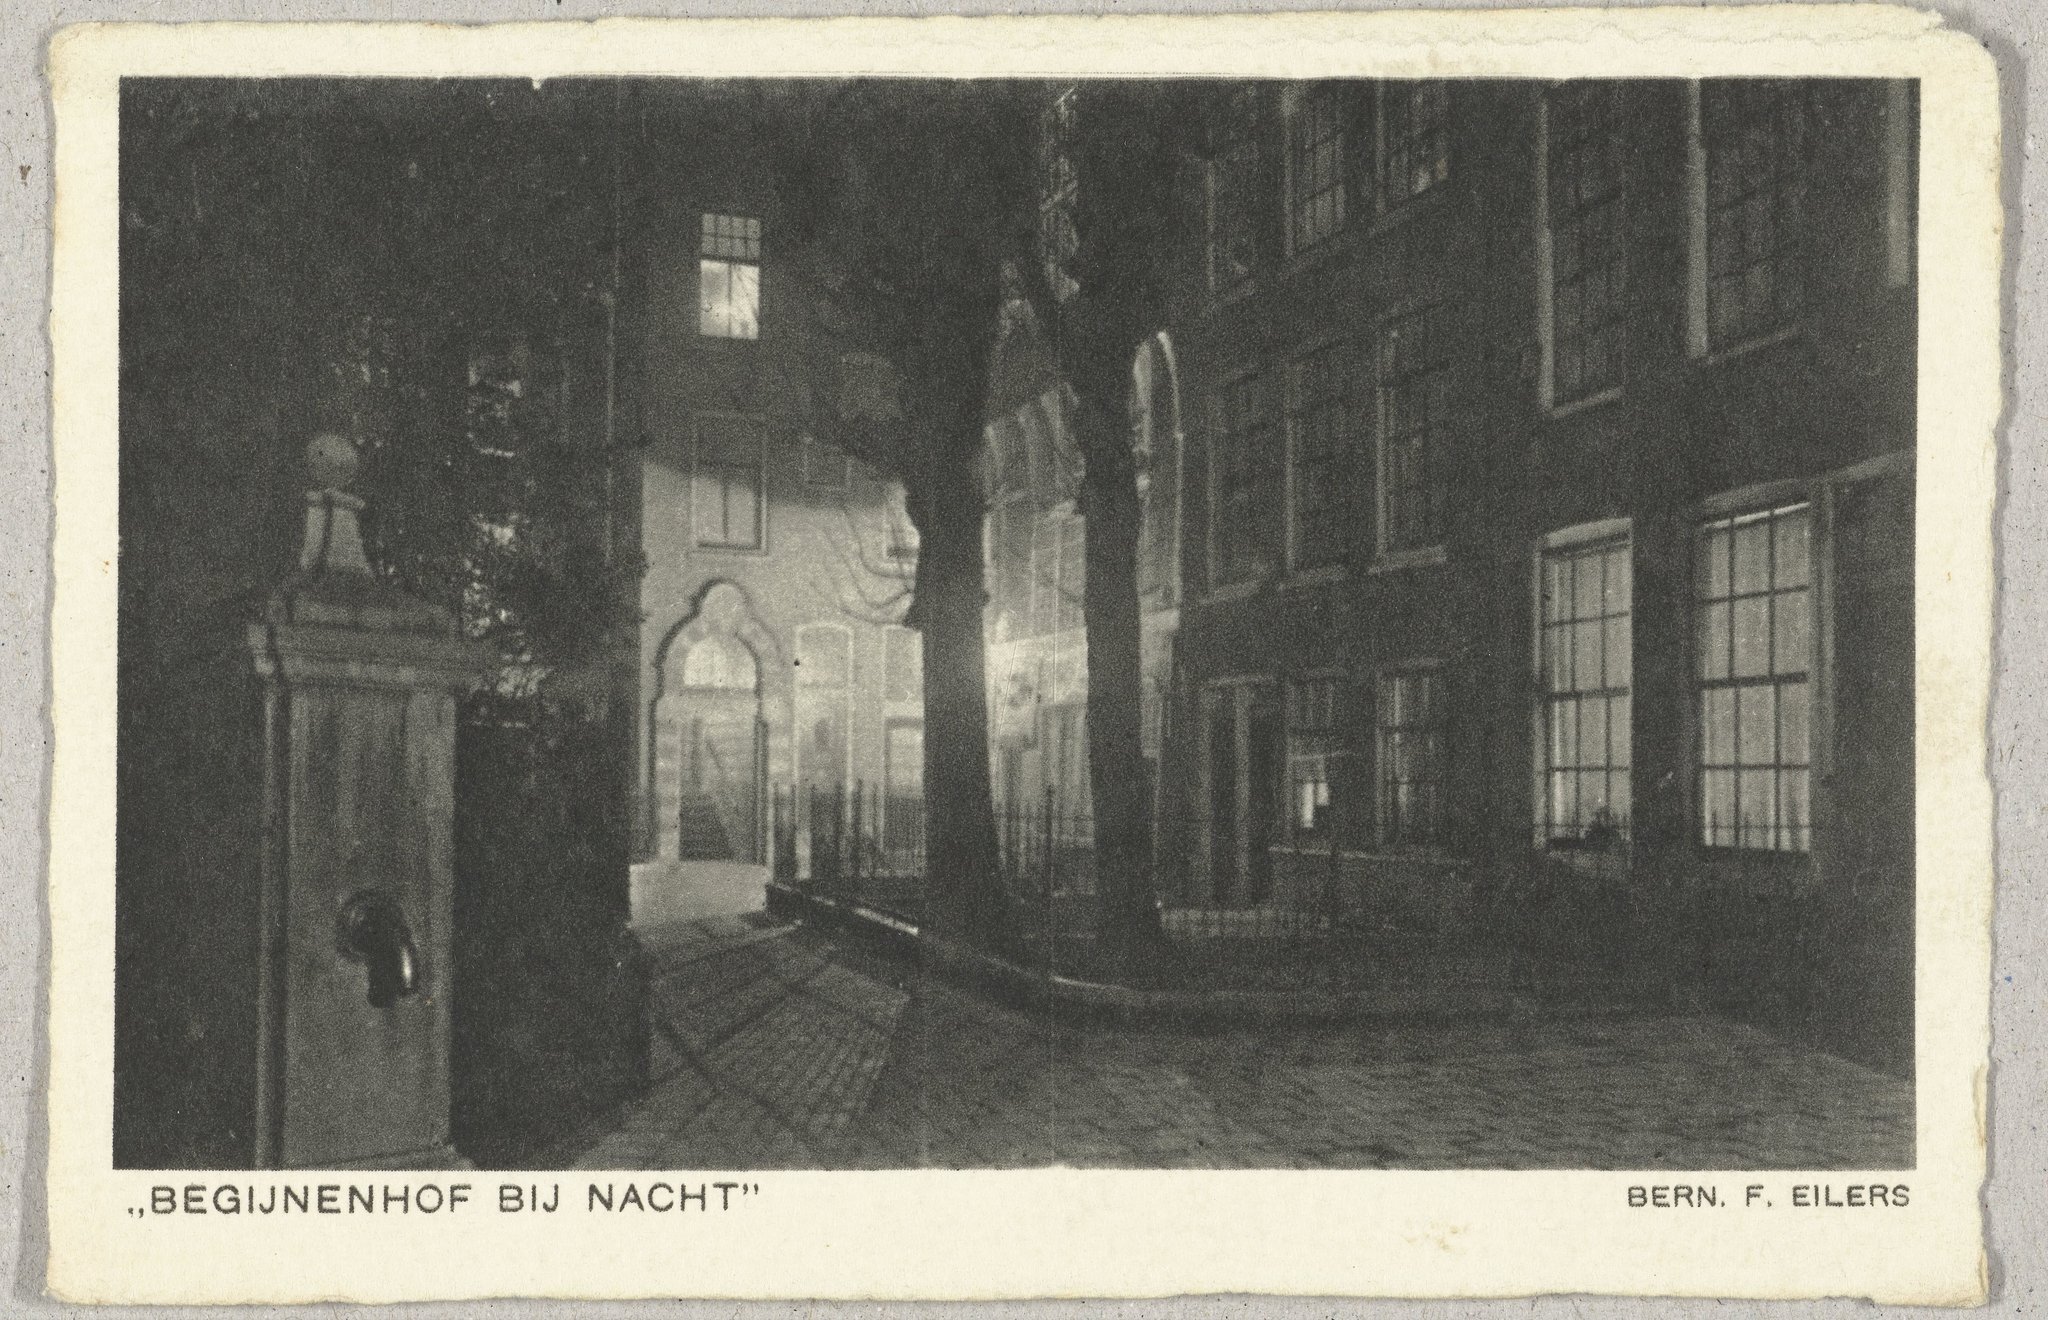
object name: photograph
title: Het Begijnhof bij nacht in Amsterdam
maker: bernard eilers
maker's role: fotograaf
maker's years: 1878-1951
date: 1913-1940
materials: paper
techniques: rotogravure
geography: amsterdam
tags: night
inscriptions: annotation: ‘serie: B, Amsterdam - Begijnenhof aan 't Spui Amsterdam ("Begijnenhof bij Nacht")’, name: ‘Bern. F. Eilers’, annotation: ‘Eilers Artistieke kaarten - uitg.-mij. "Kosmos" - Amsterdam’